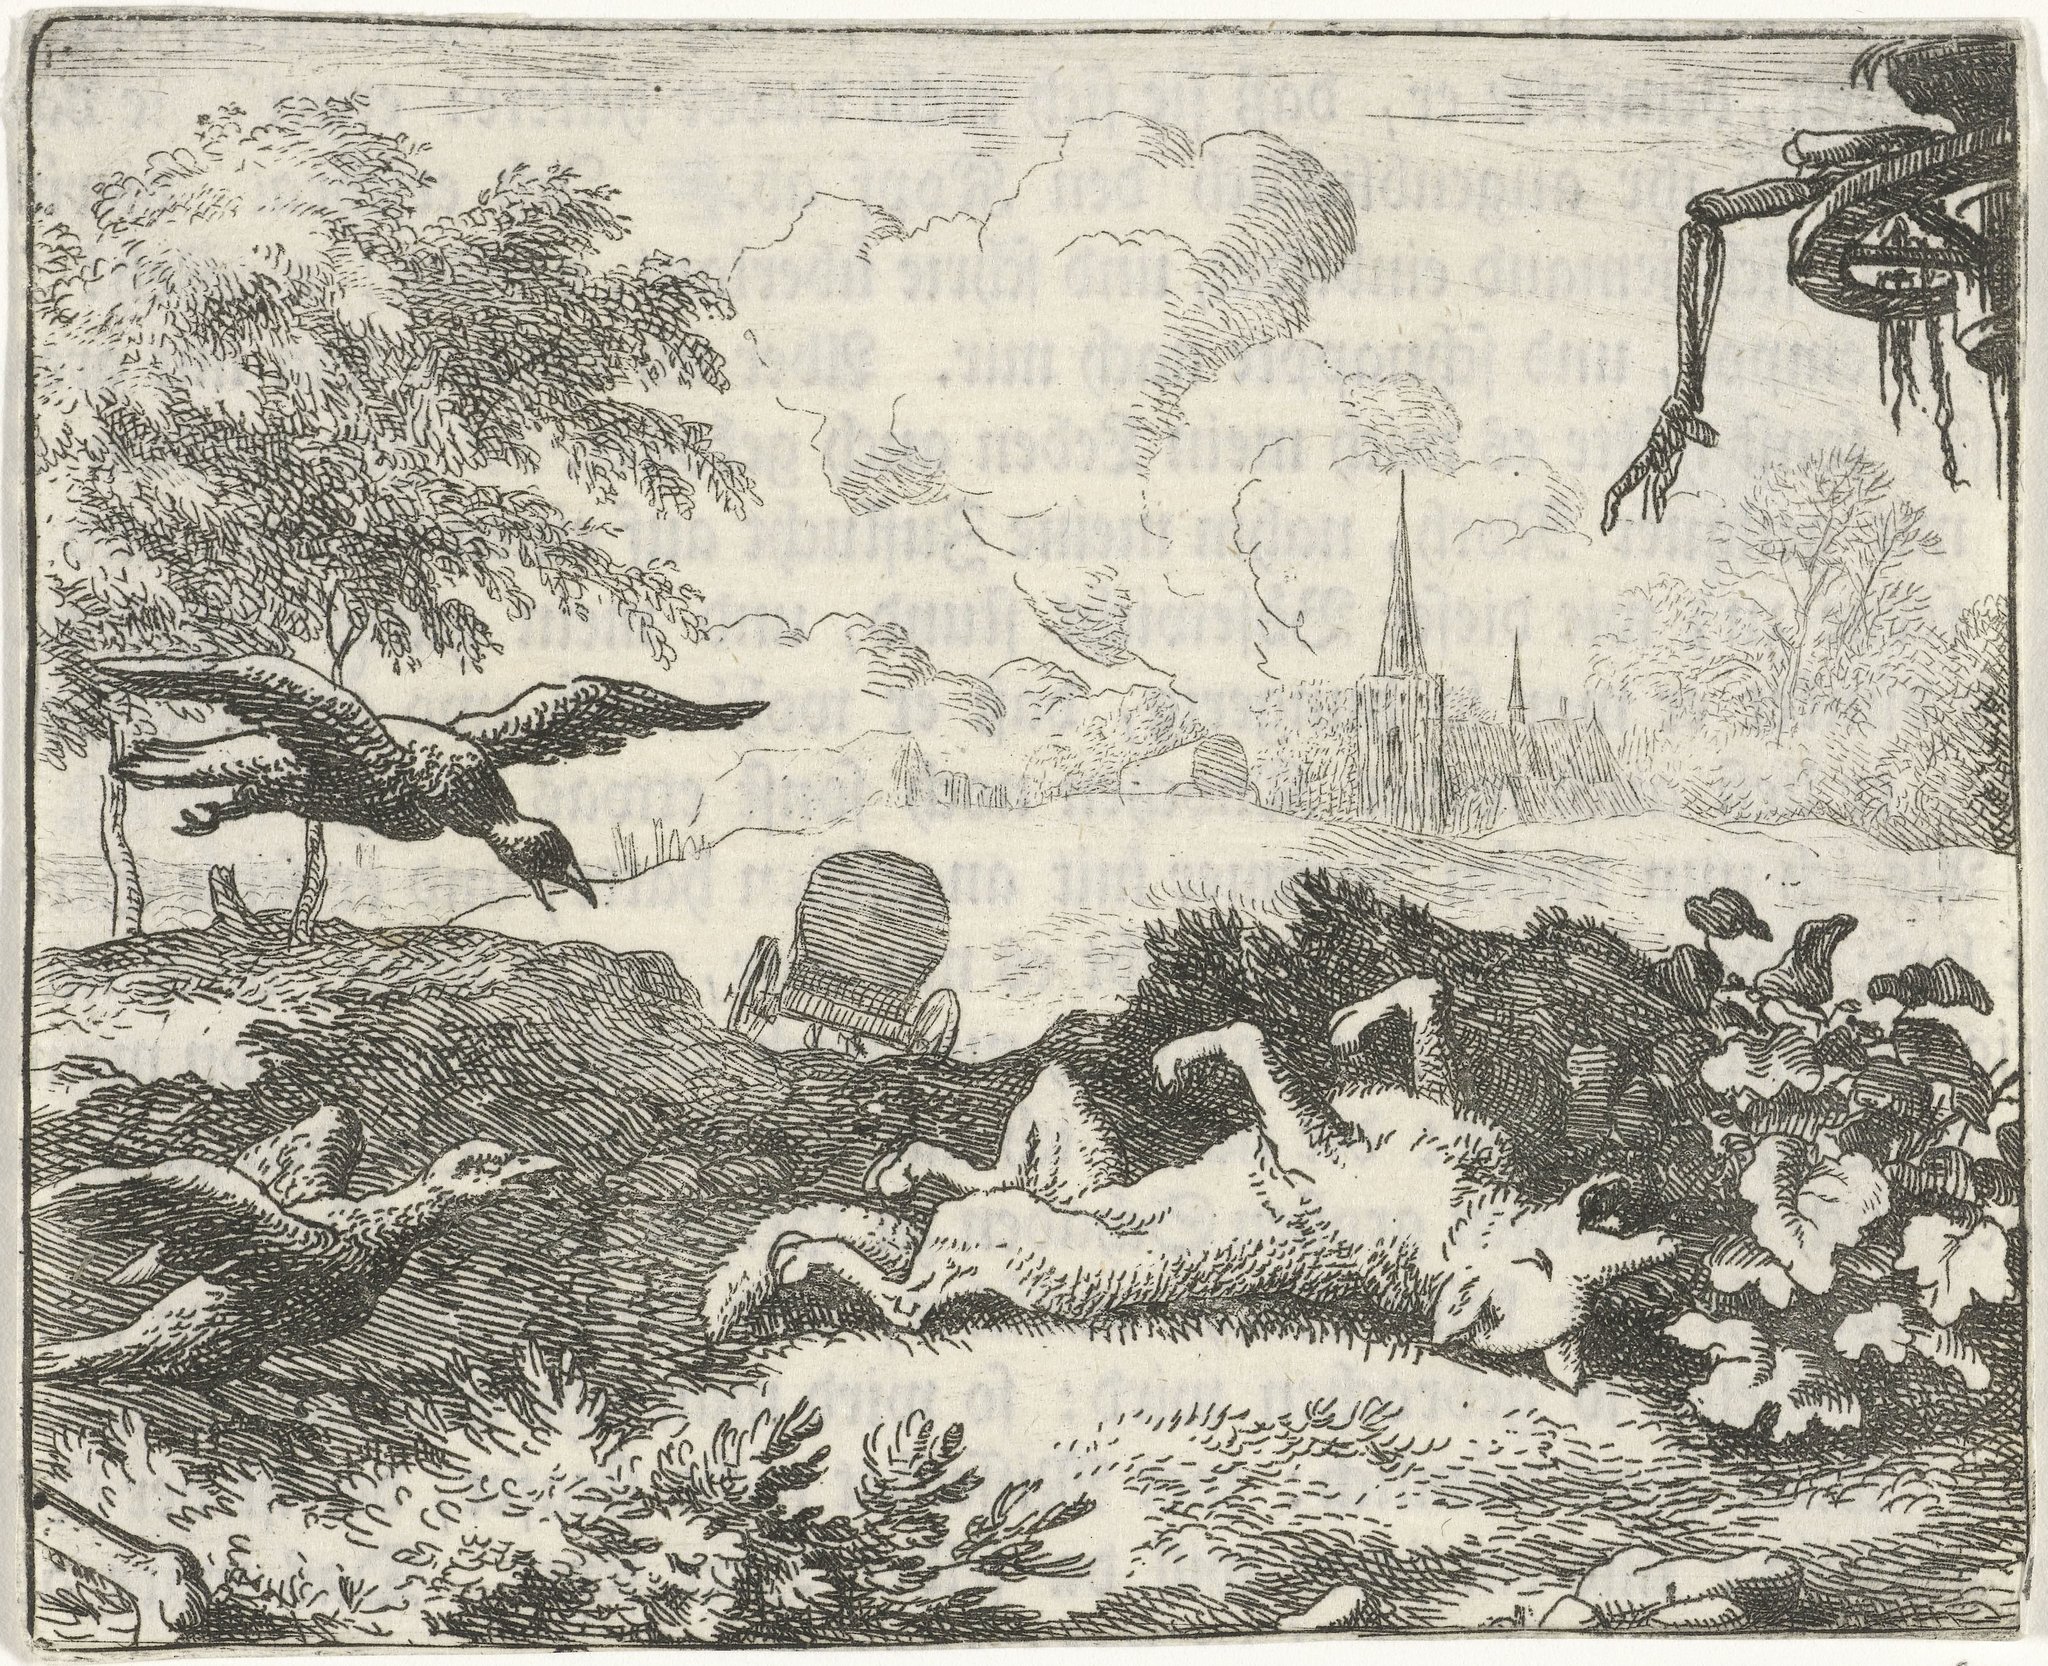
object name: print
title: Illustraties voor Reijntje de Vos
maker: allaert van everdingen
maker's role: draughtsman, painter, print maker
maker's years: 1621-1675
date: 1665-1675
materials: paper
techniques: etching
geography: netherlands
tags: fable of reynard the fox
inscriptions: collector's mark: Lugt 2228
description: Reinaert de vos ligt op zijn rug in het gras. Op de achterkant van de prent een Duits tekstfragment uit het verhaal van Reinaert de vos.